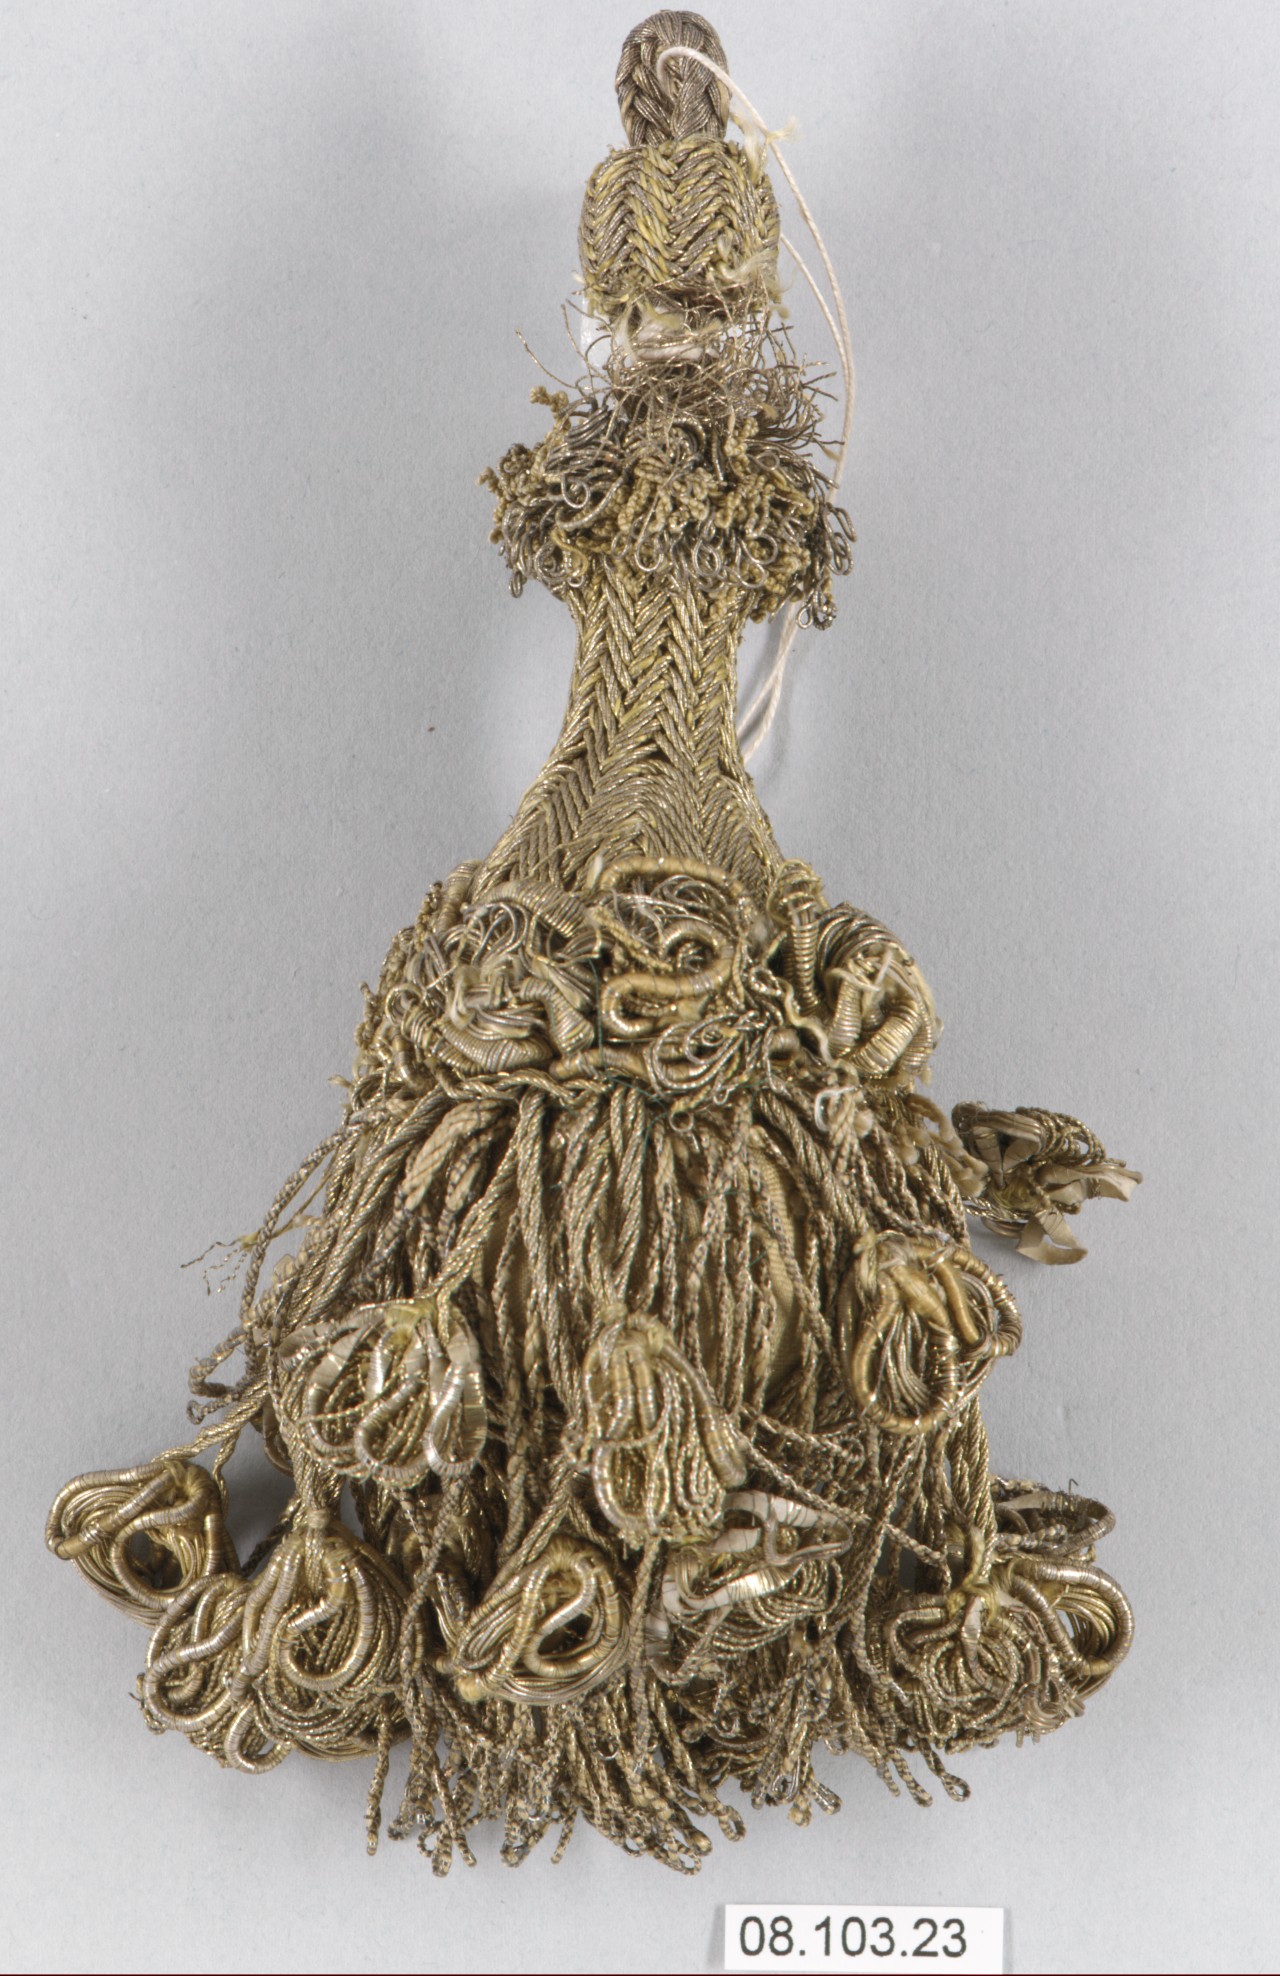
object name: tassel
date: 1701-1900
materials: metal thread